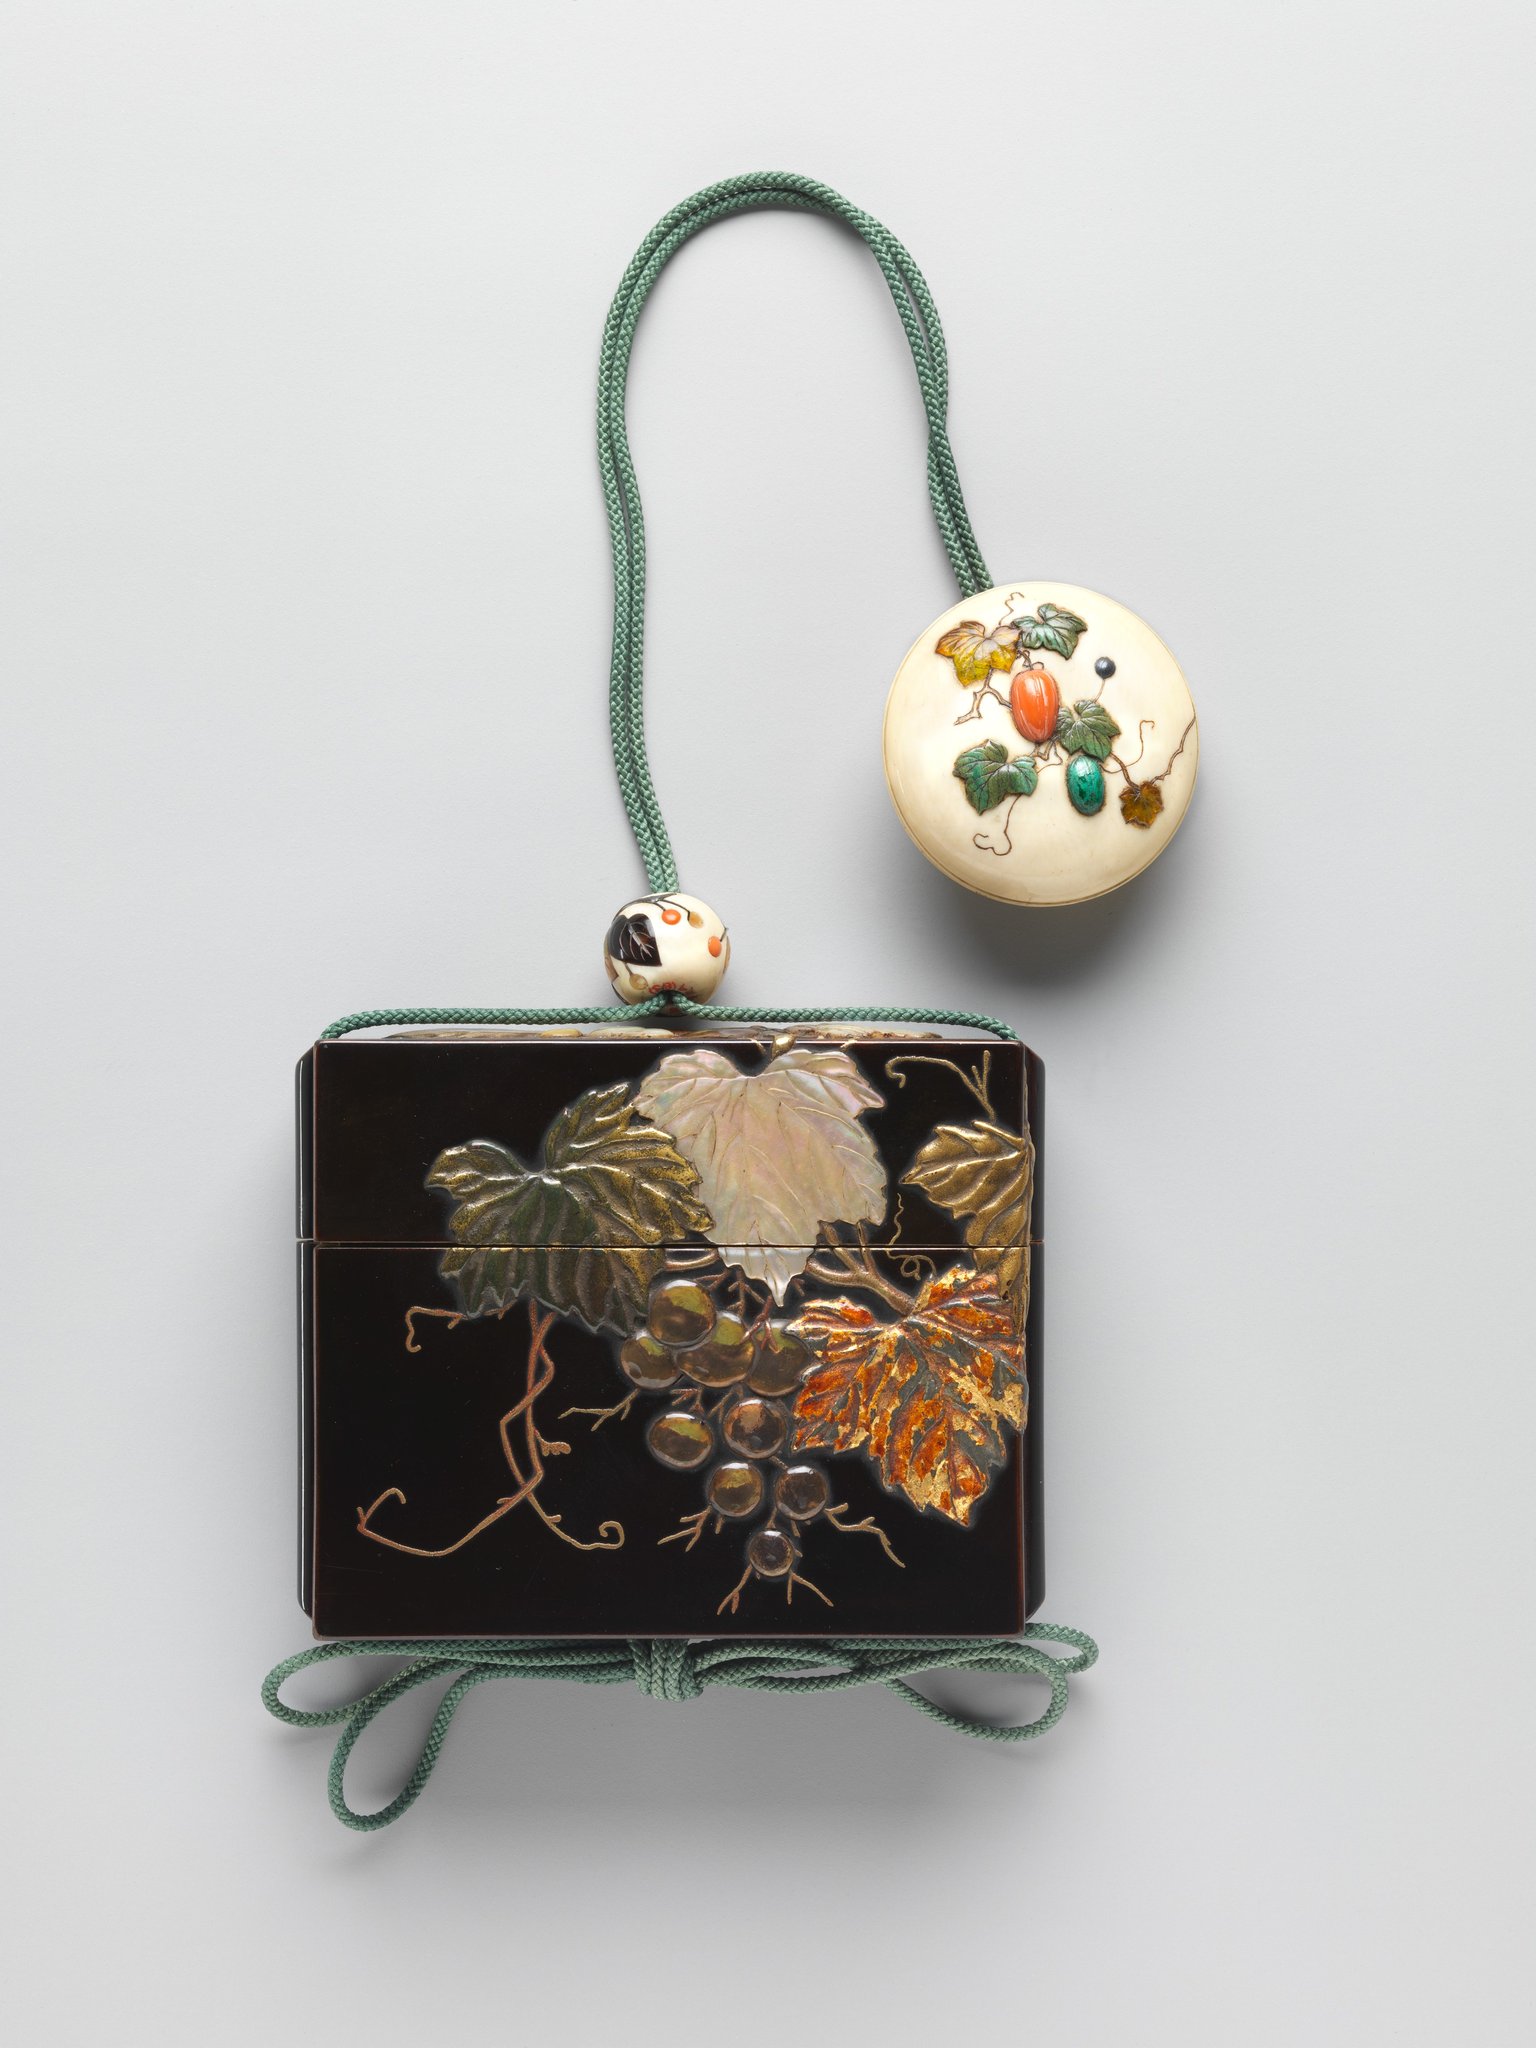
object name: inrō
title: Inrō with Grapevine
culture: japanese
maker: nomura choheisai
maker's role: artist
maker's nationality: japanese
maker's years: 1750-1799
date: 1751-1800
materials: amber, gold, gold foil, horn, ivory, lacquer, mother of pearl, wood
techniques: hiramakie, inlay, lacquer, stain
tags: grapes